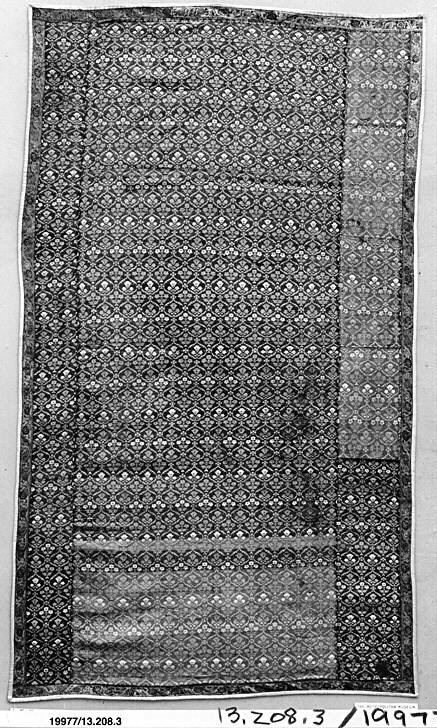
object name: silk weave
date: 1701-1800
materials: silk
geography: iran